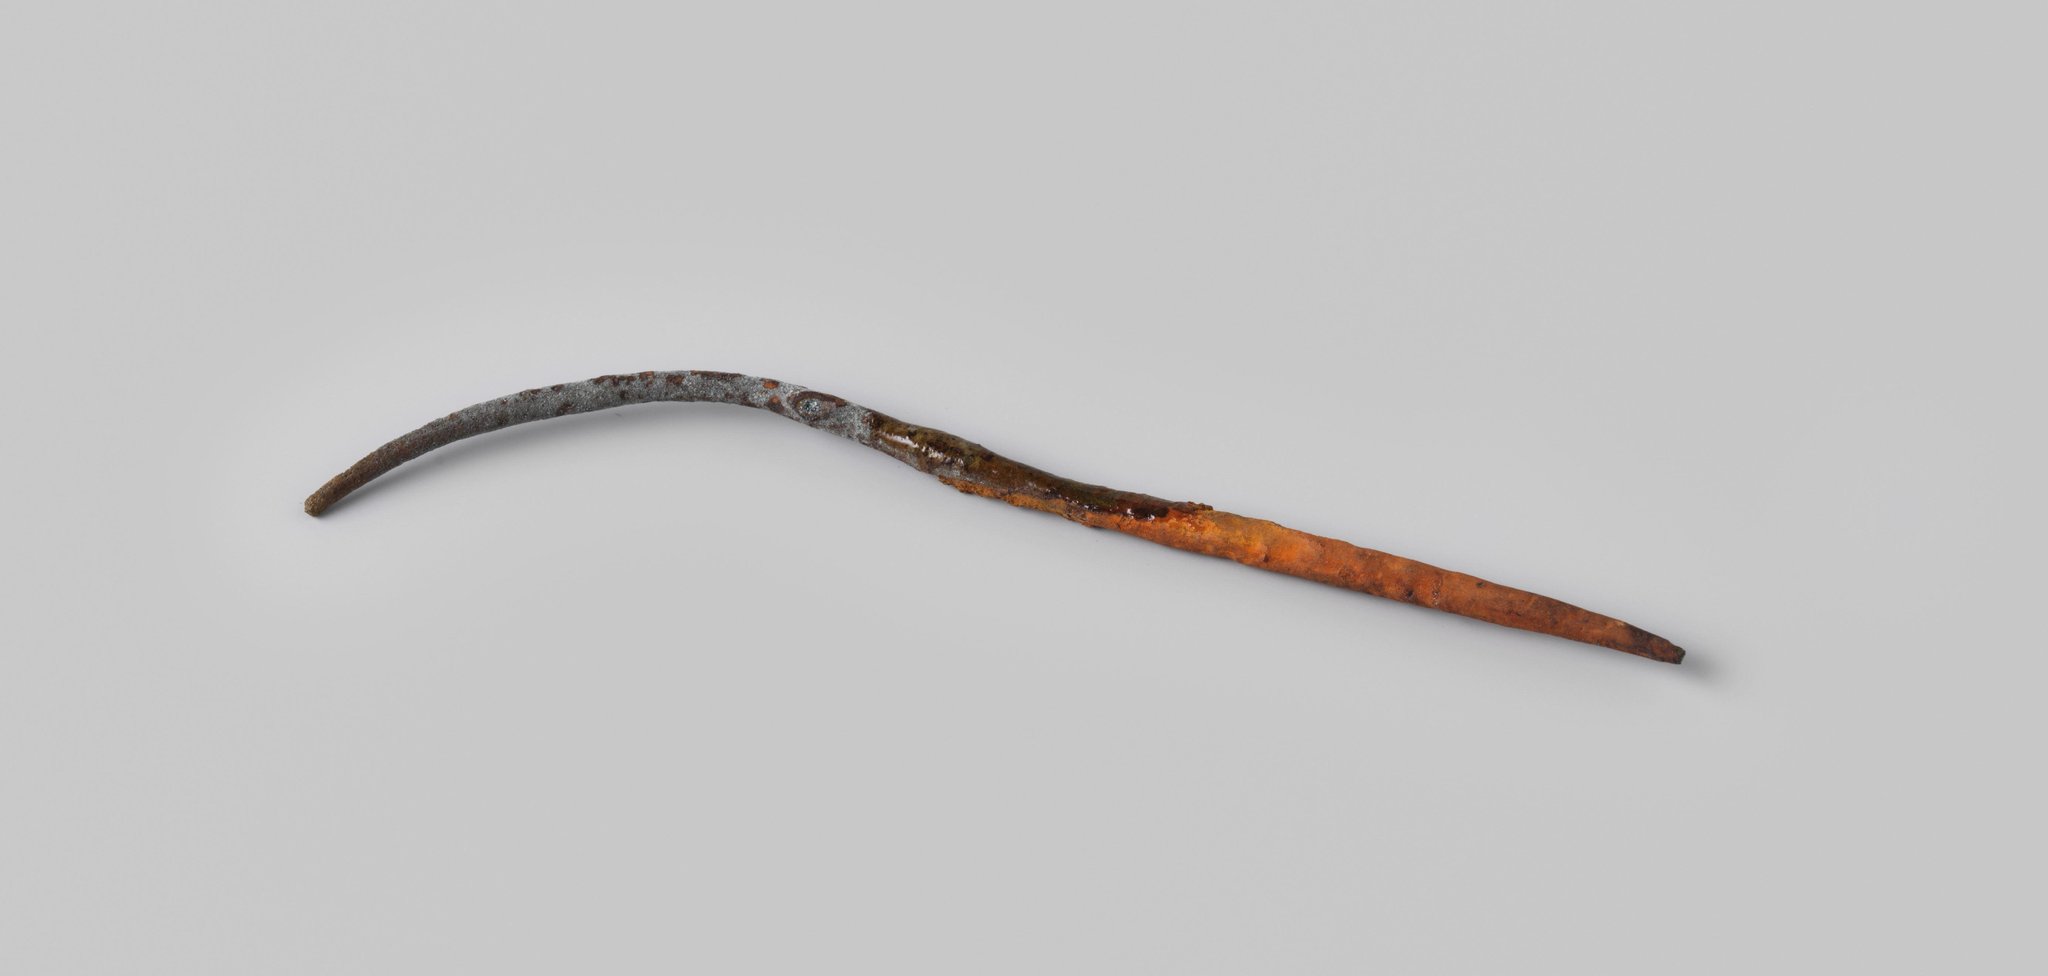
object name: wire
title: Zilverdraad uit het wrak van de Oost-Indiëvaarder Hollandia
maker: Anonymous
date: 1700-1743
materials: silver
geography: netherlands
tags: verenigde oostindische compagnie, hollandia (schip), annet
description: Varied parts or fragments, wire; fragm, eroded, circular in section.